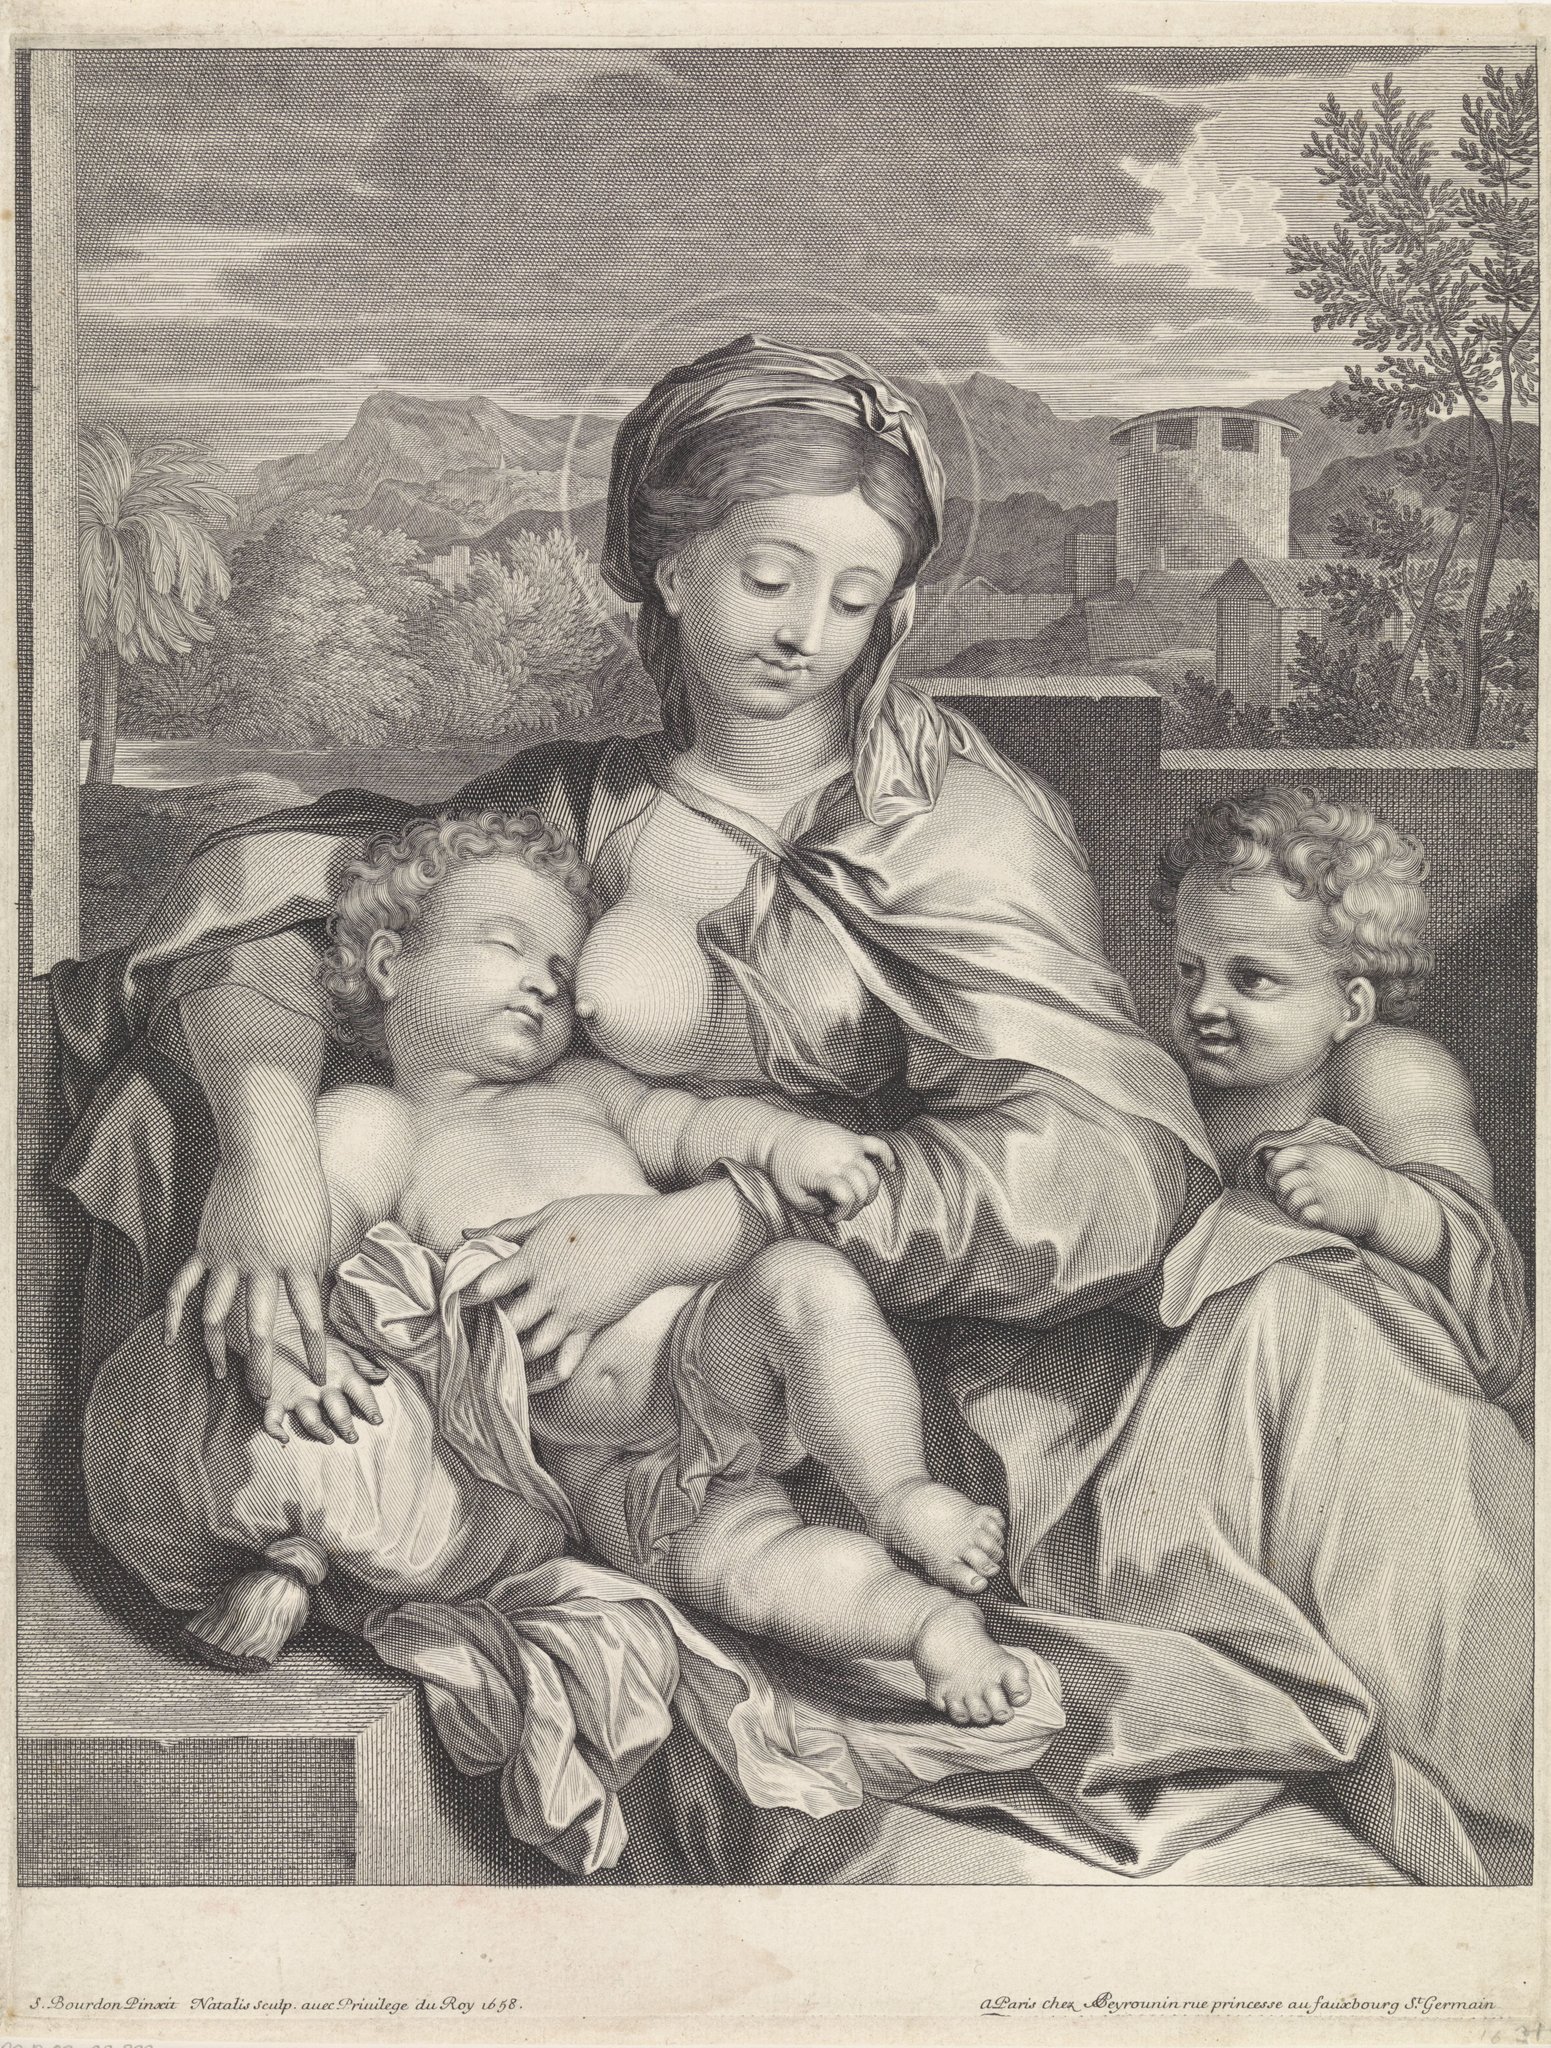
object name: print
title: Maria met Christuskind en Johannes de Doper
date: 1658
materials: paper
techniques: engraving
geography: paris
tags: adoration of the christ-child by mary; john the baptist present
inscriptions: collector's mark: Lugt 2166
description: Maria met één ontblote borst, het slapende Christuskind in haar armen. Rechts Johannes de Doper, die naar het Christuskind kijkt. Op de achtergrond een bergachtig landschap en gebouwen.